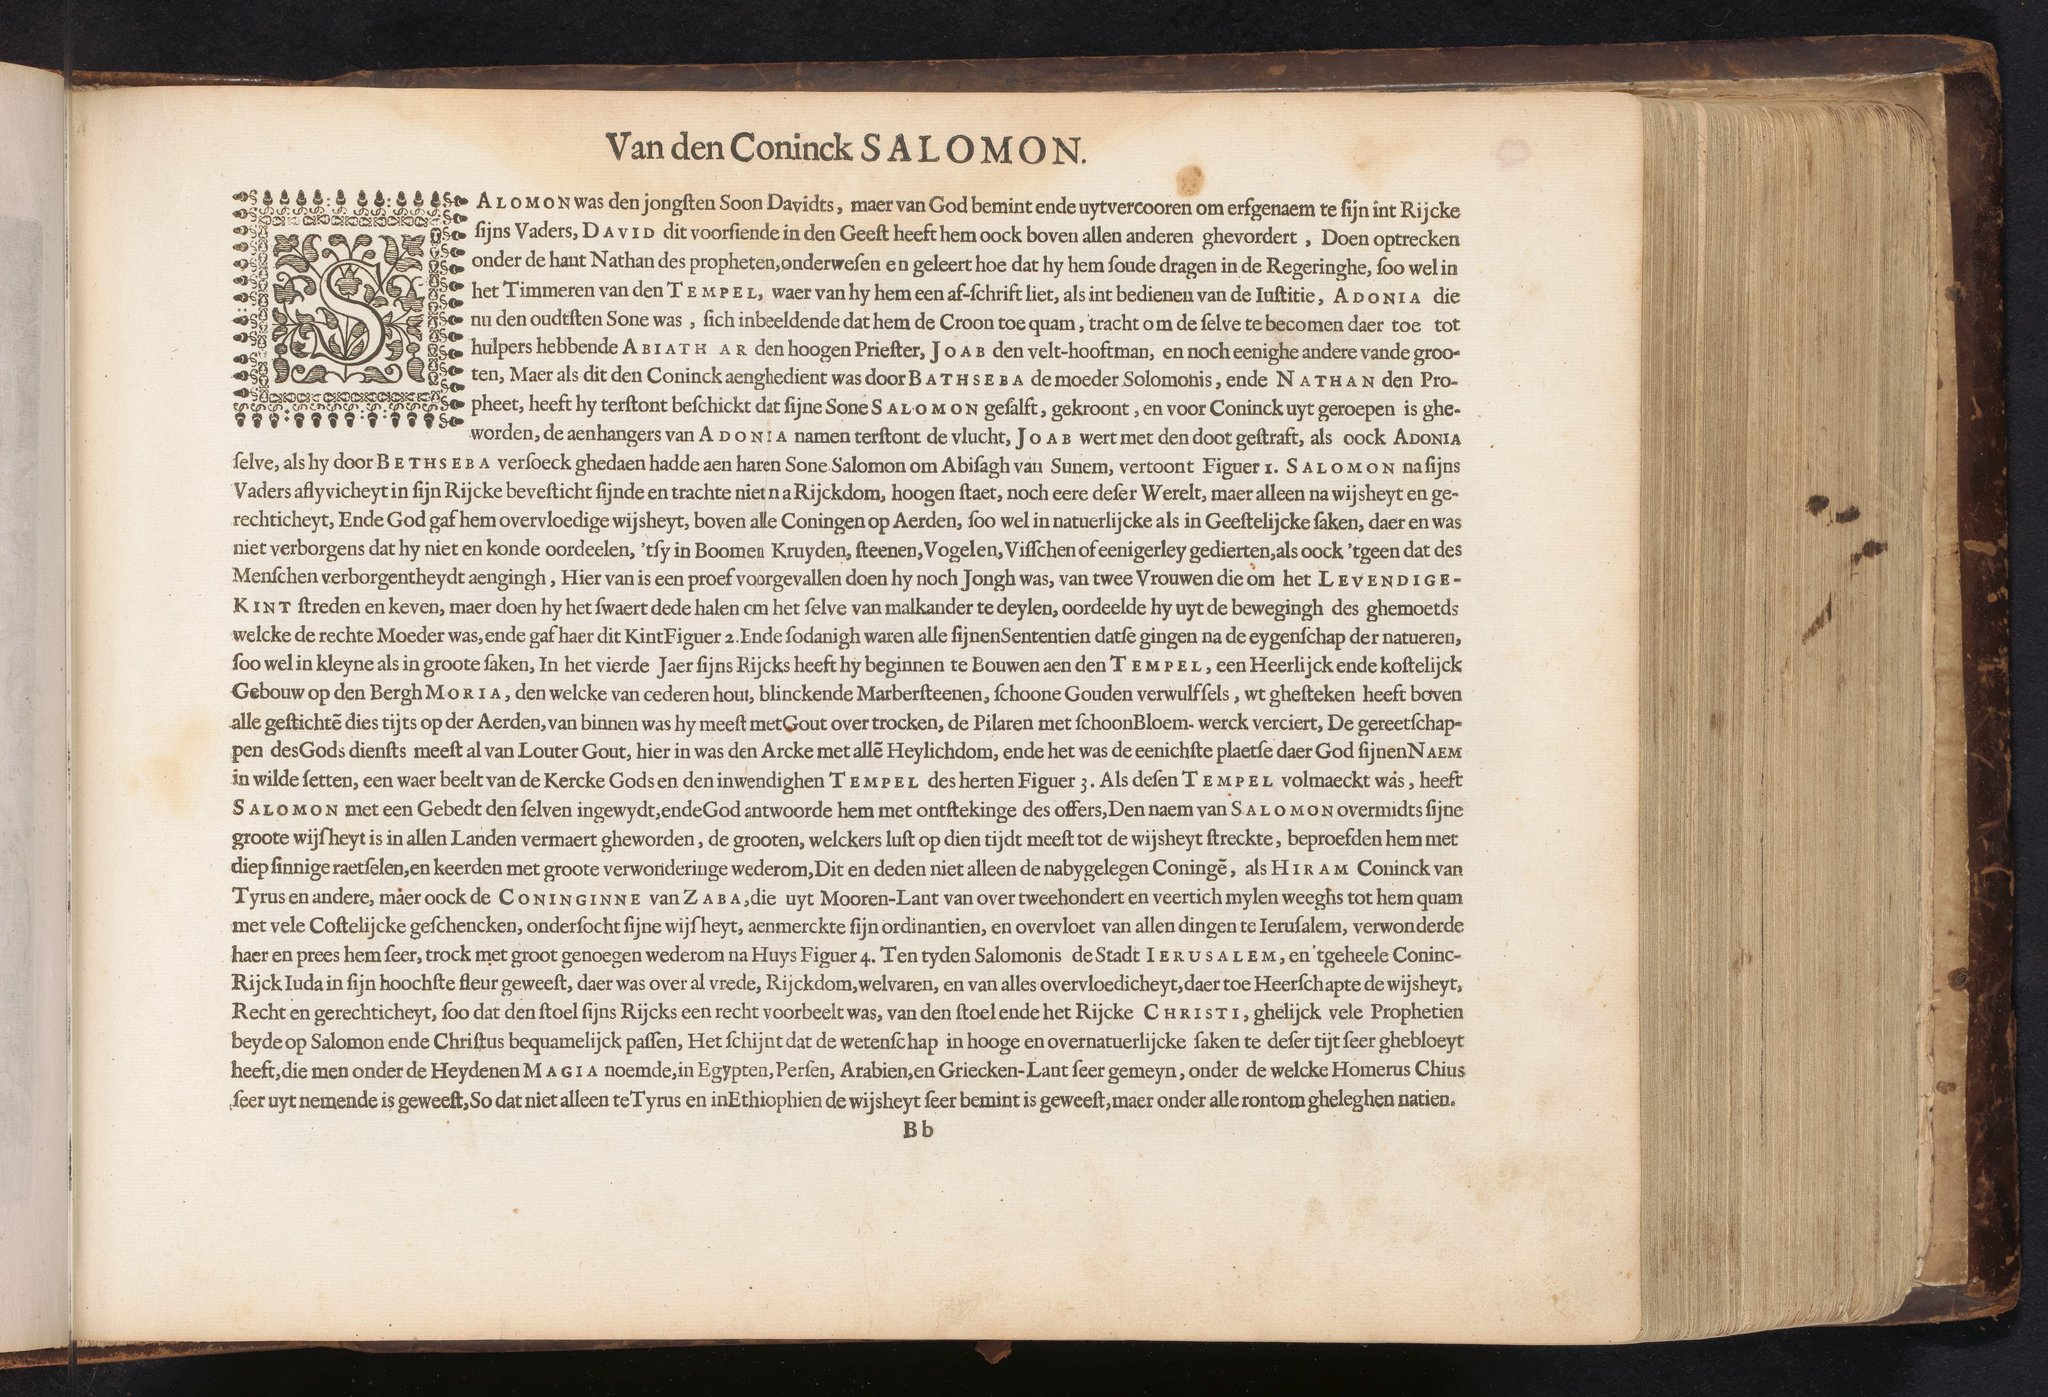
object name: text sheet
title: Den Grooten Figuer-Bibel (...)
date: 1646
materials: paper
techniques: letterpress printing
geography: alkmaar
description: Tekstblad bij een serie prenten over de geschiedenis van Salomo. Linksboven initiaal S. Dit blad maakt deel uit van een album.